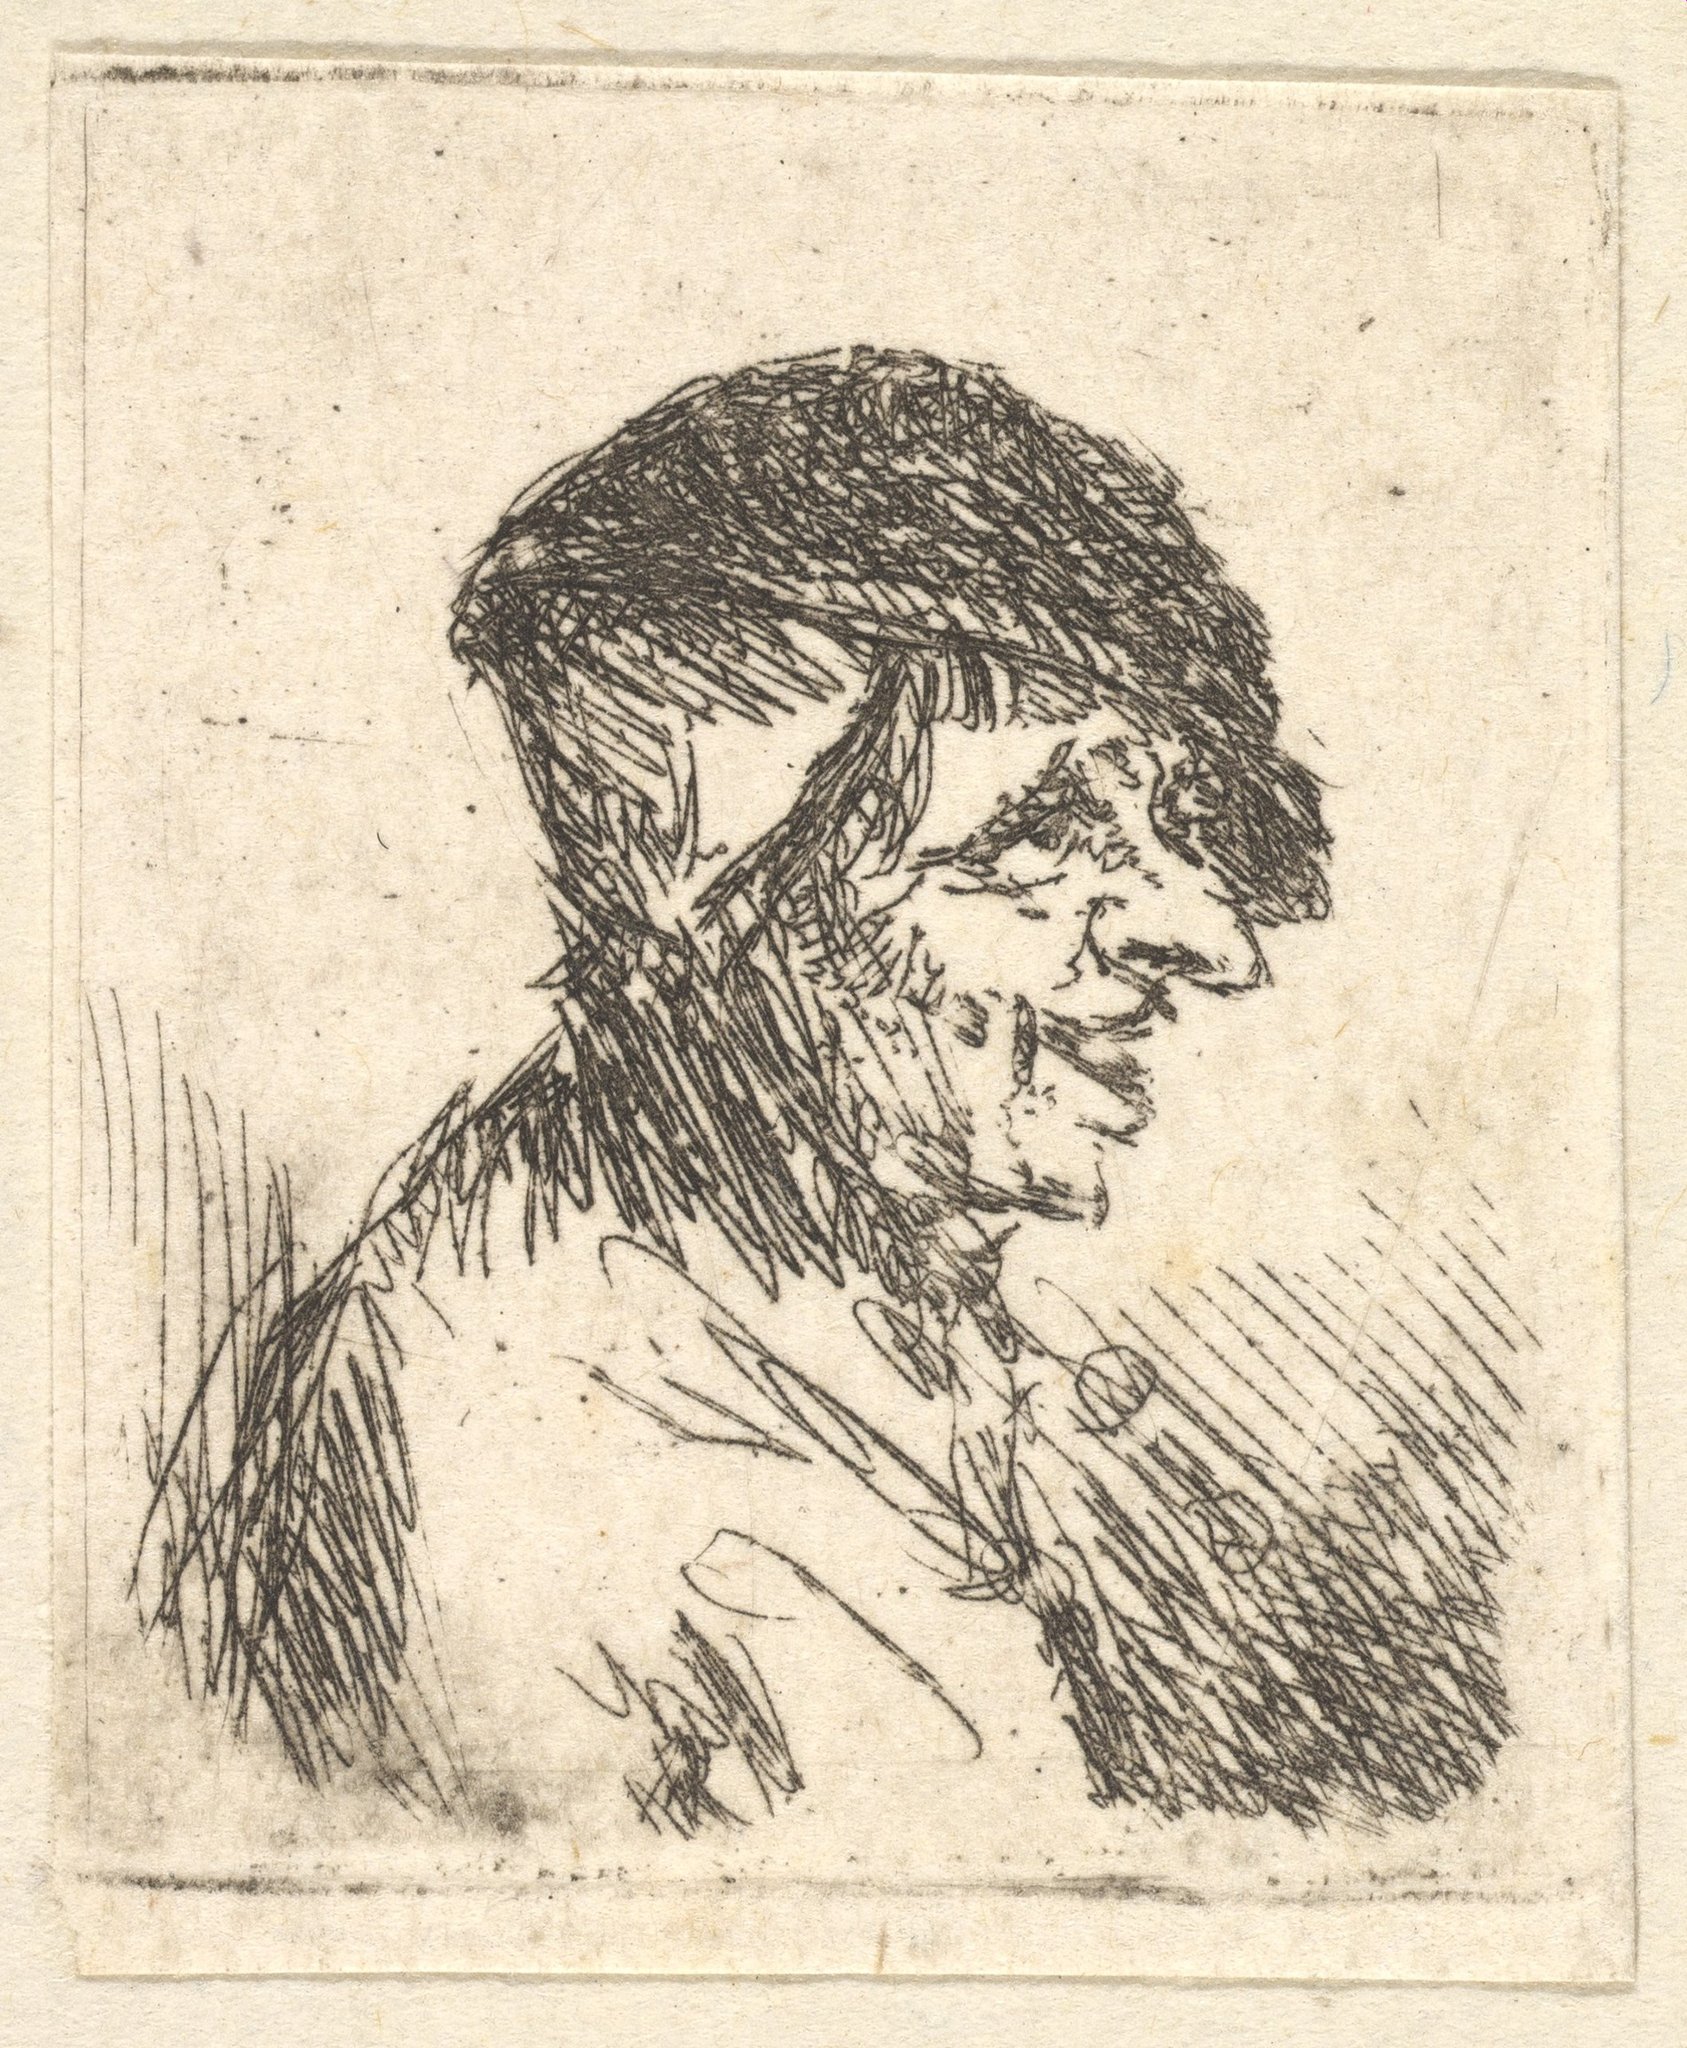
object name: print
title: Head of Peasant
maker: adriaen van ostade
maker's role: artist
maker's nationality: dutch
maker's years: 1610-1685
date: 1601-1700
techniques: etching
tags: men,profiles